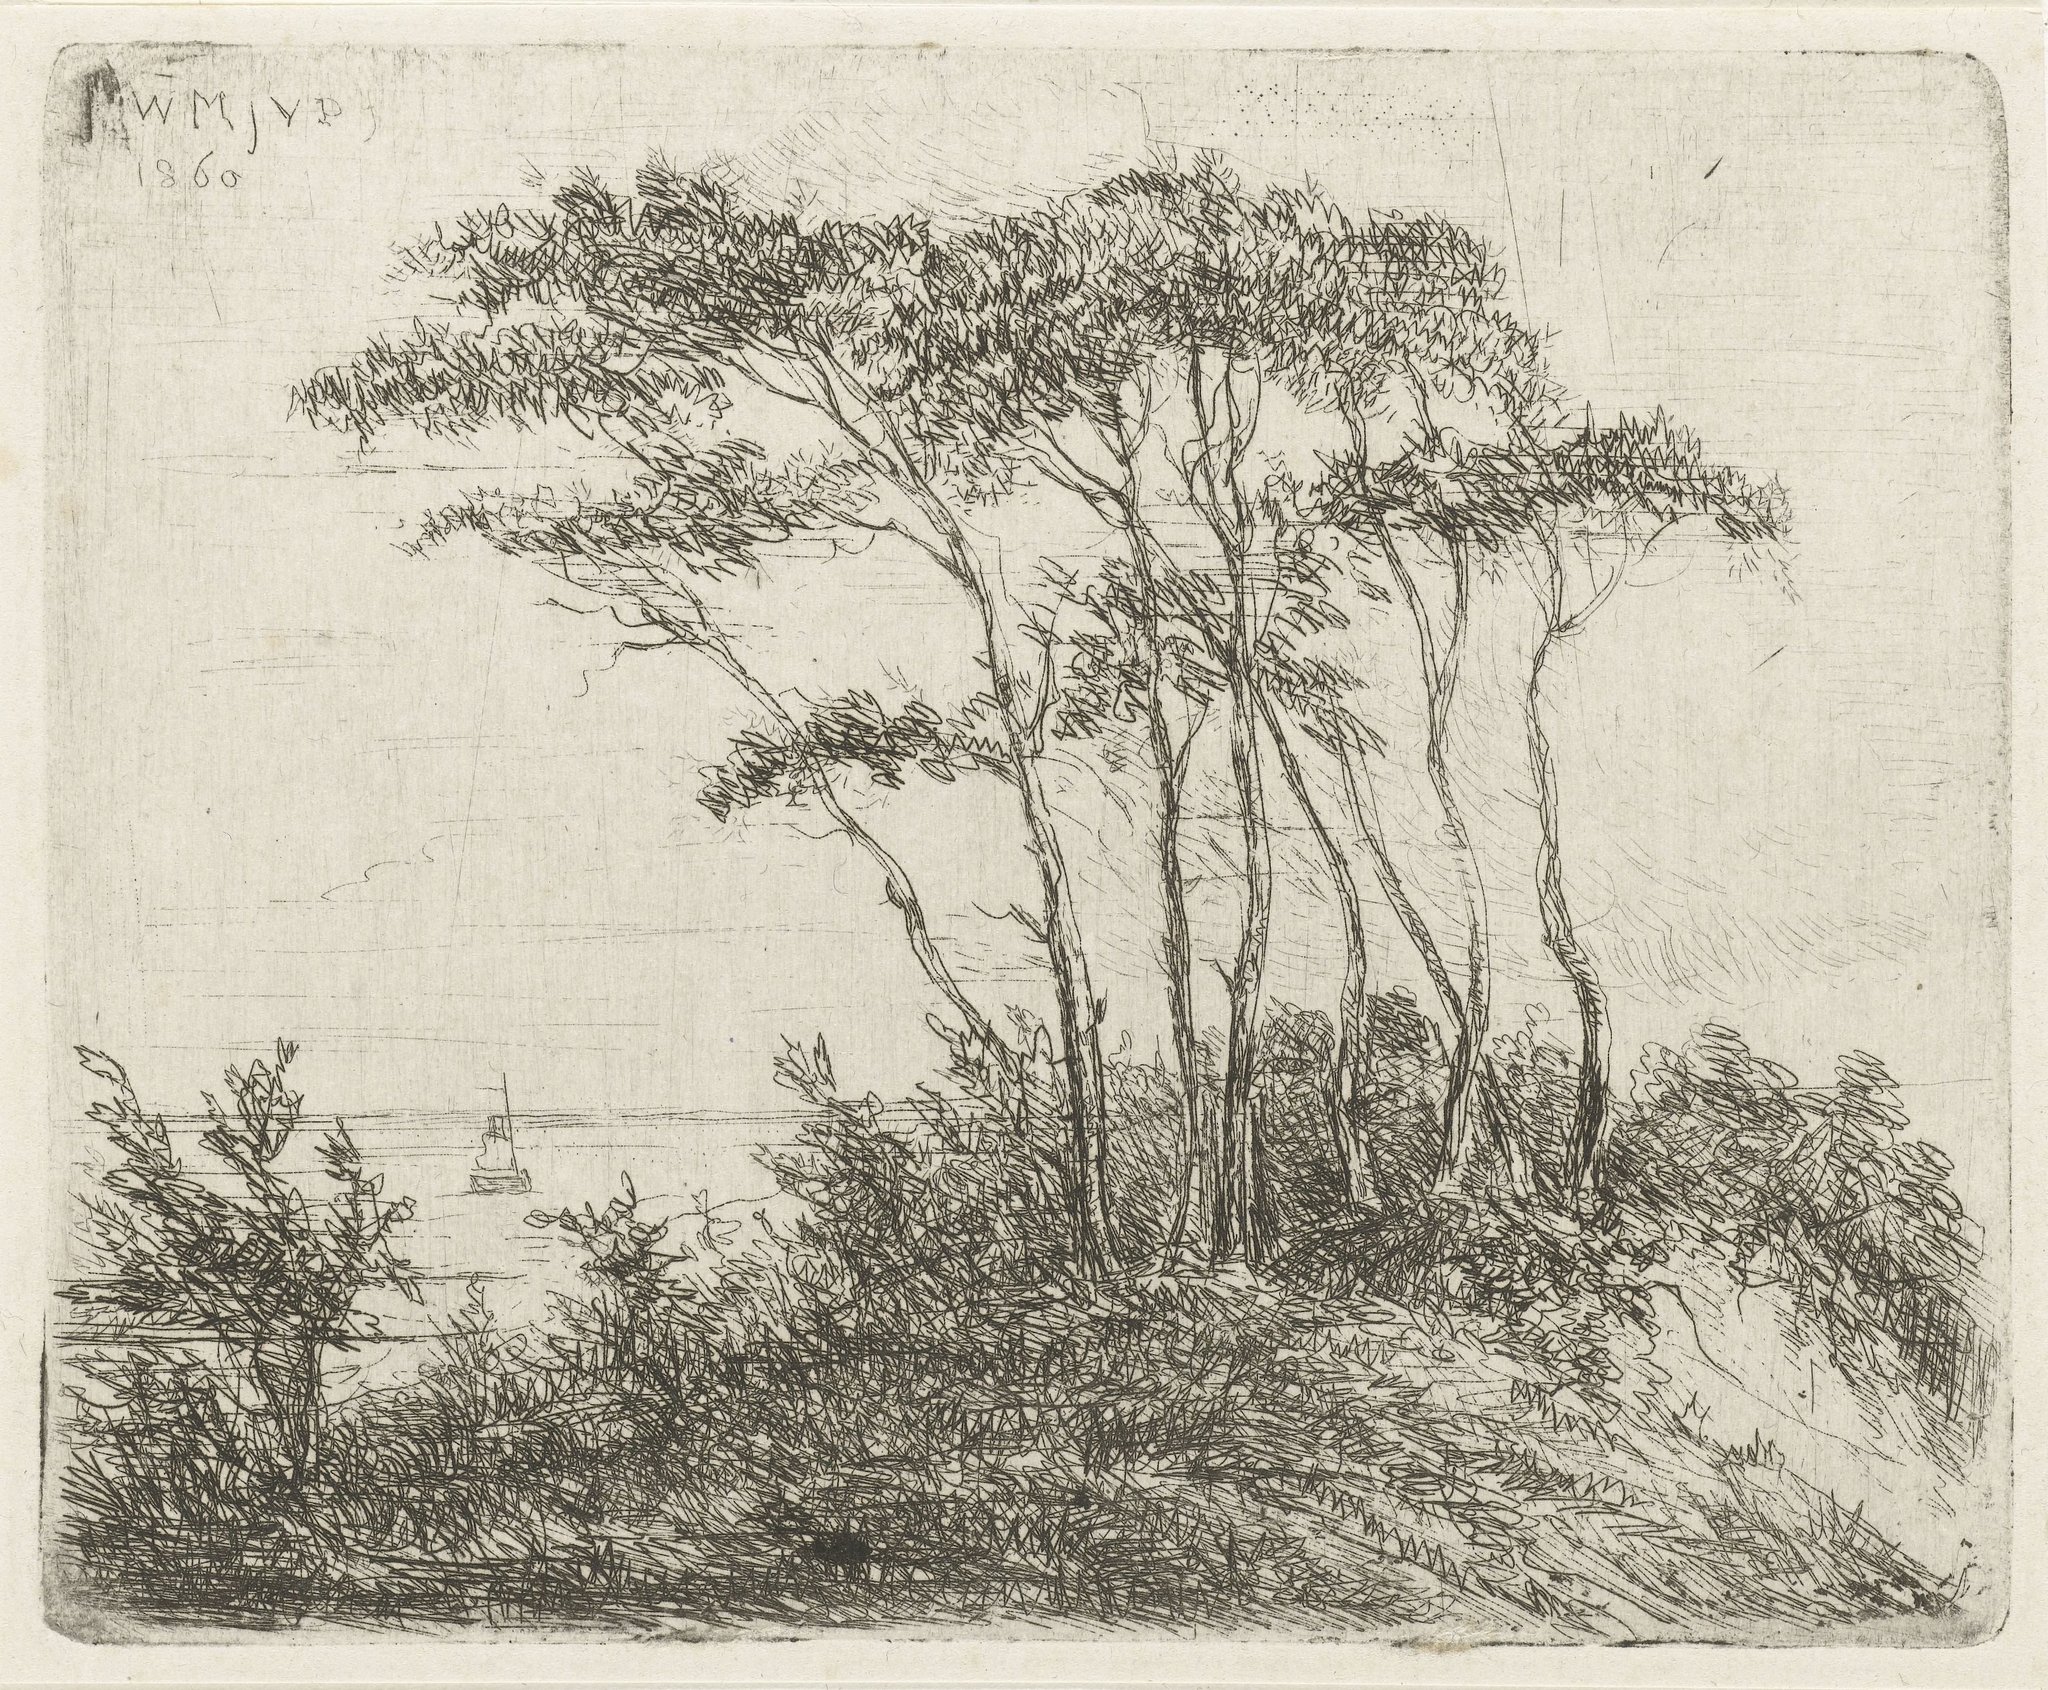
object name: print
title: Kustlandschap met groep bomen op duin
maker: willem matthias jan van dielen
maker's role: print maker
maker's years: 1805-1867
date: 1860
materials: paper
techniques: etching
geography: netherlands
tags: dune coast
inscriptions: collector's mark: Lugt 2228